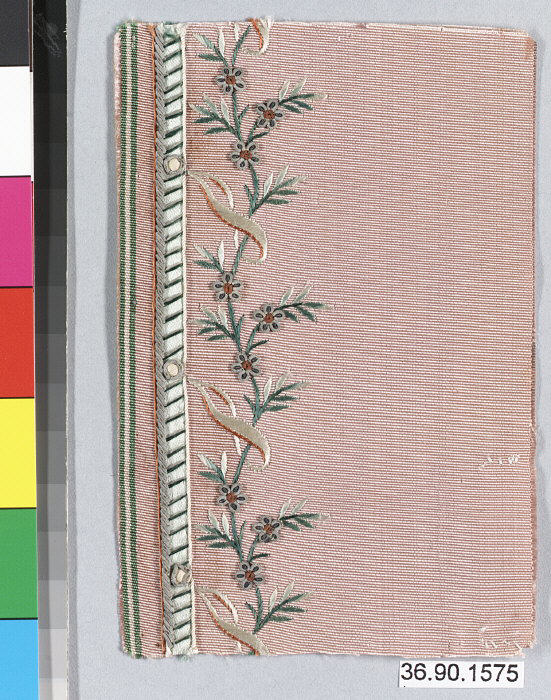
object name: sample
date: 1801-1833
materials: metal thread, silk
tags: flowers